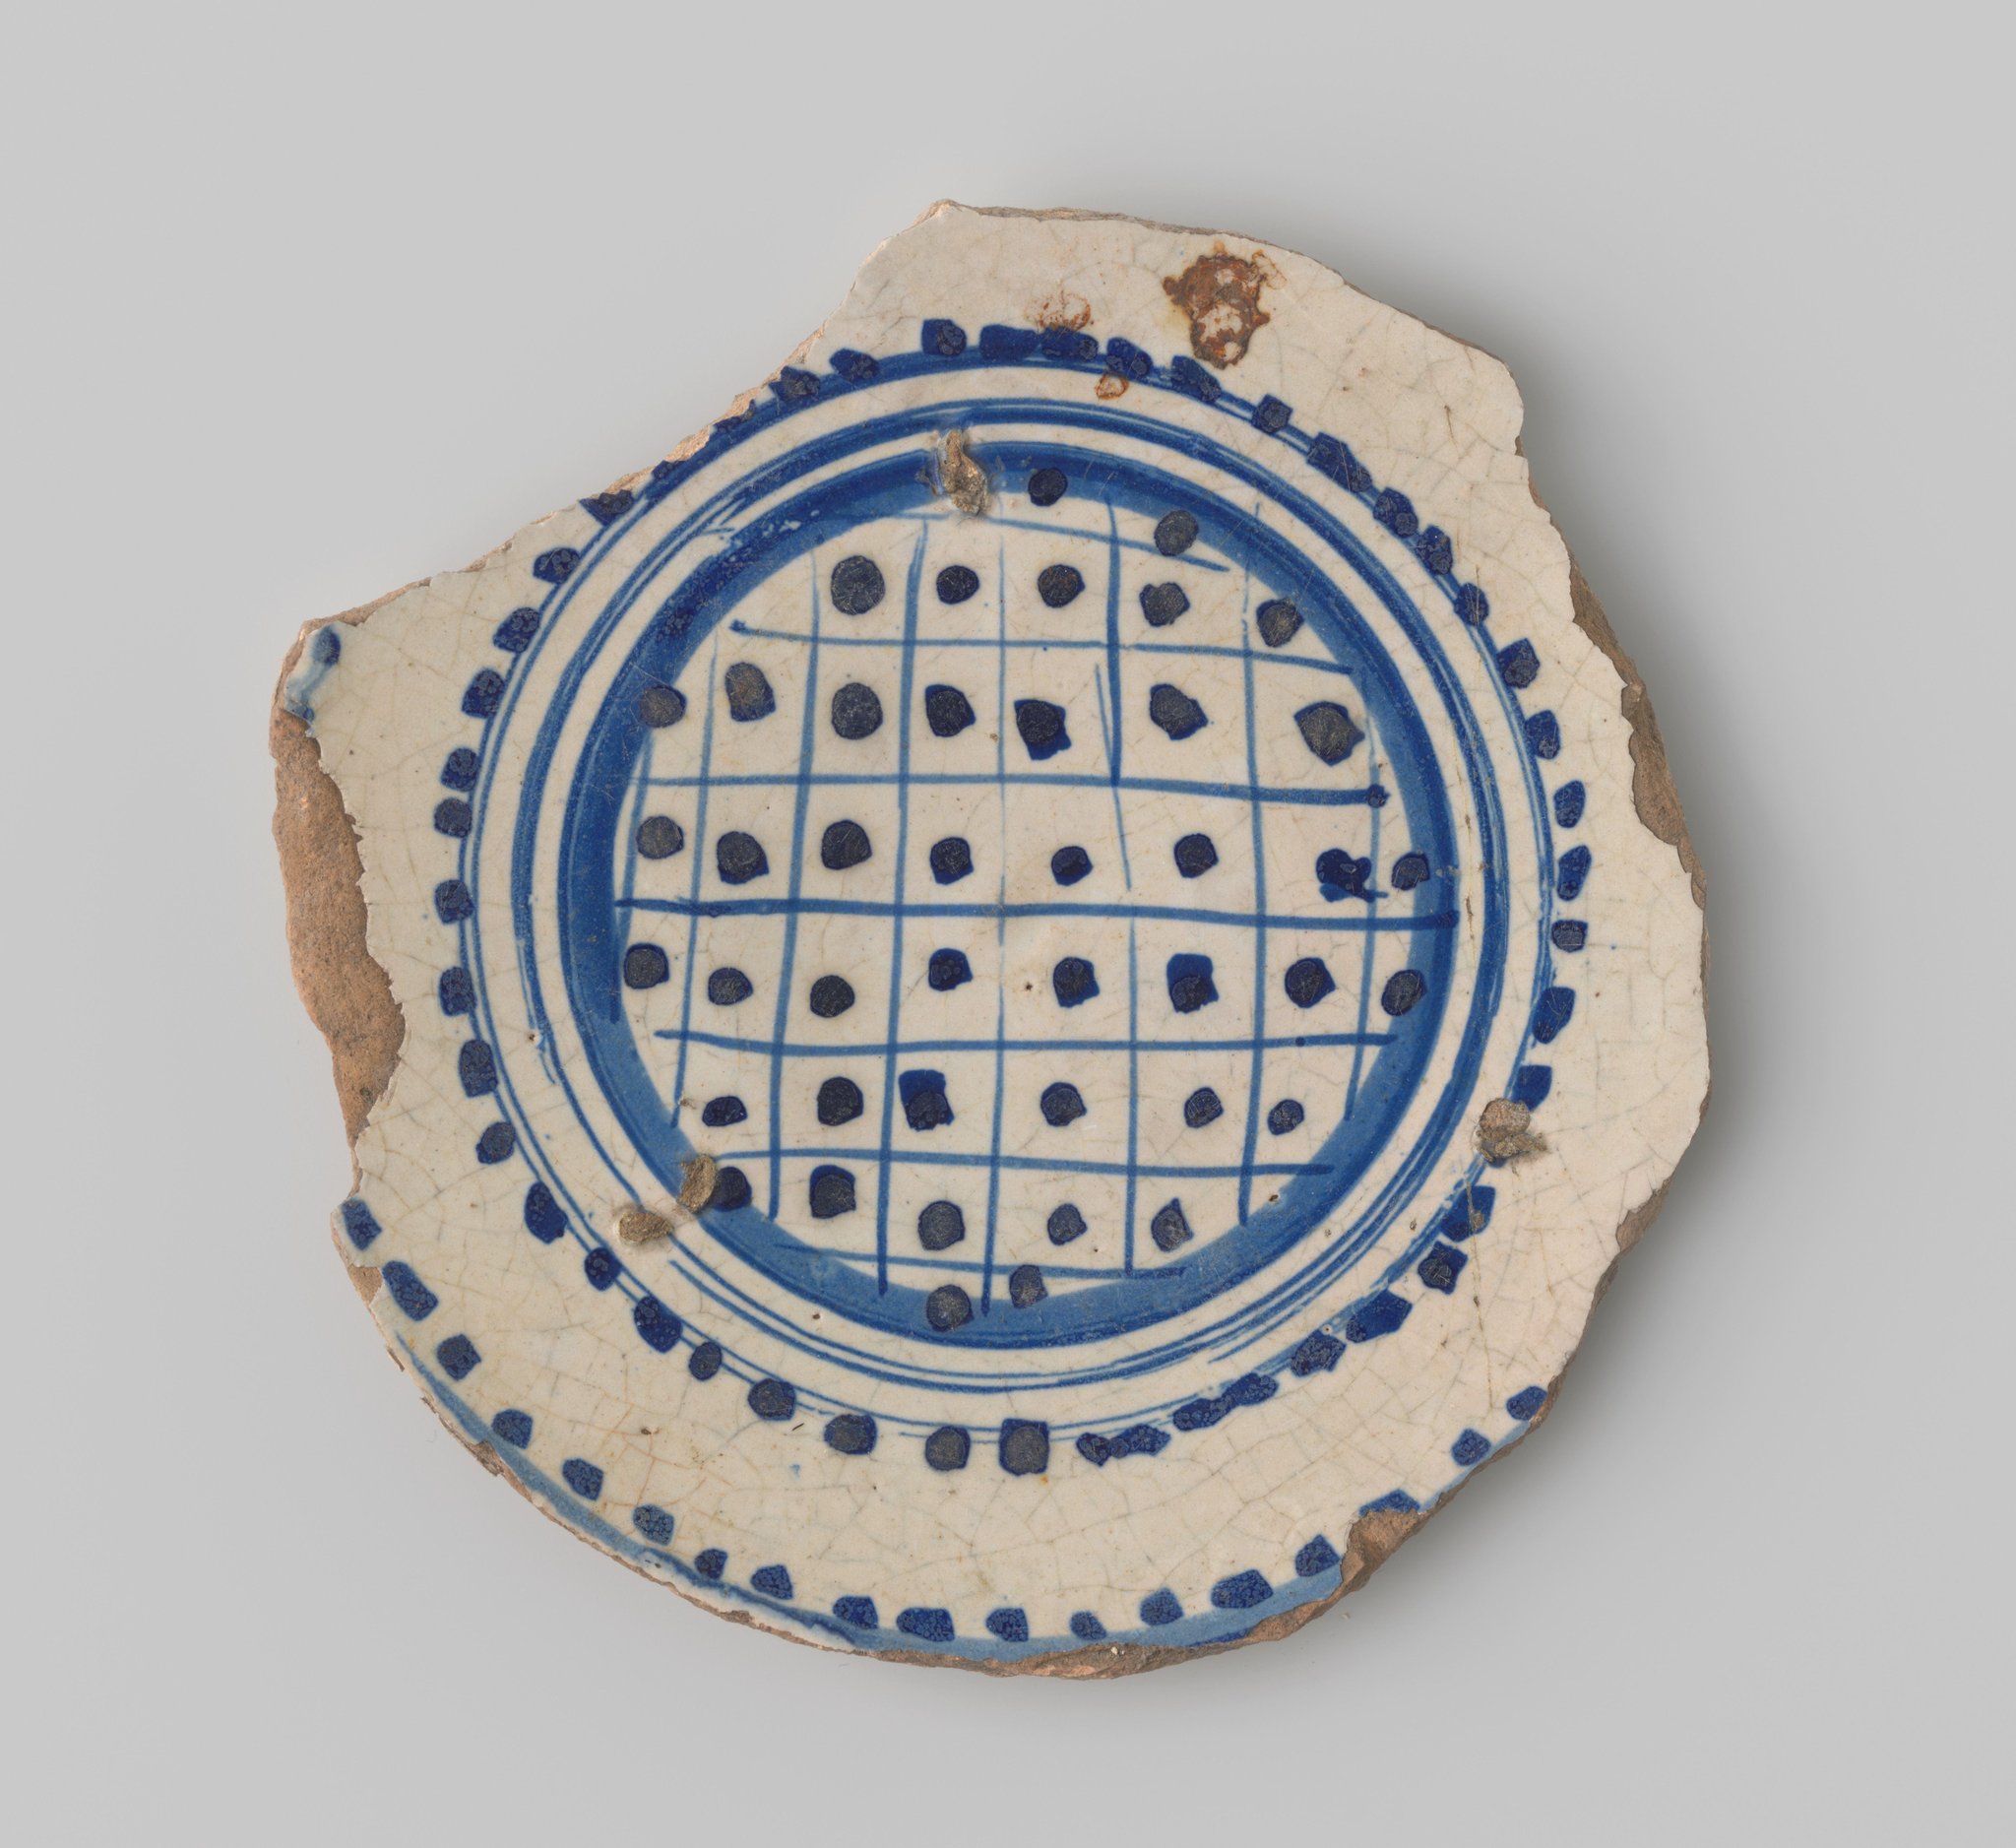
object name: sherd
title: Schotelfragment van aardewerk voorzien van loodglazuur aan de achterzijde en tinglazuur met blauwe decoratie aan de voorzijde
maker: Anonymous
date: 1600-1620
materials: earthenware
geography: northern netherlands